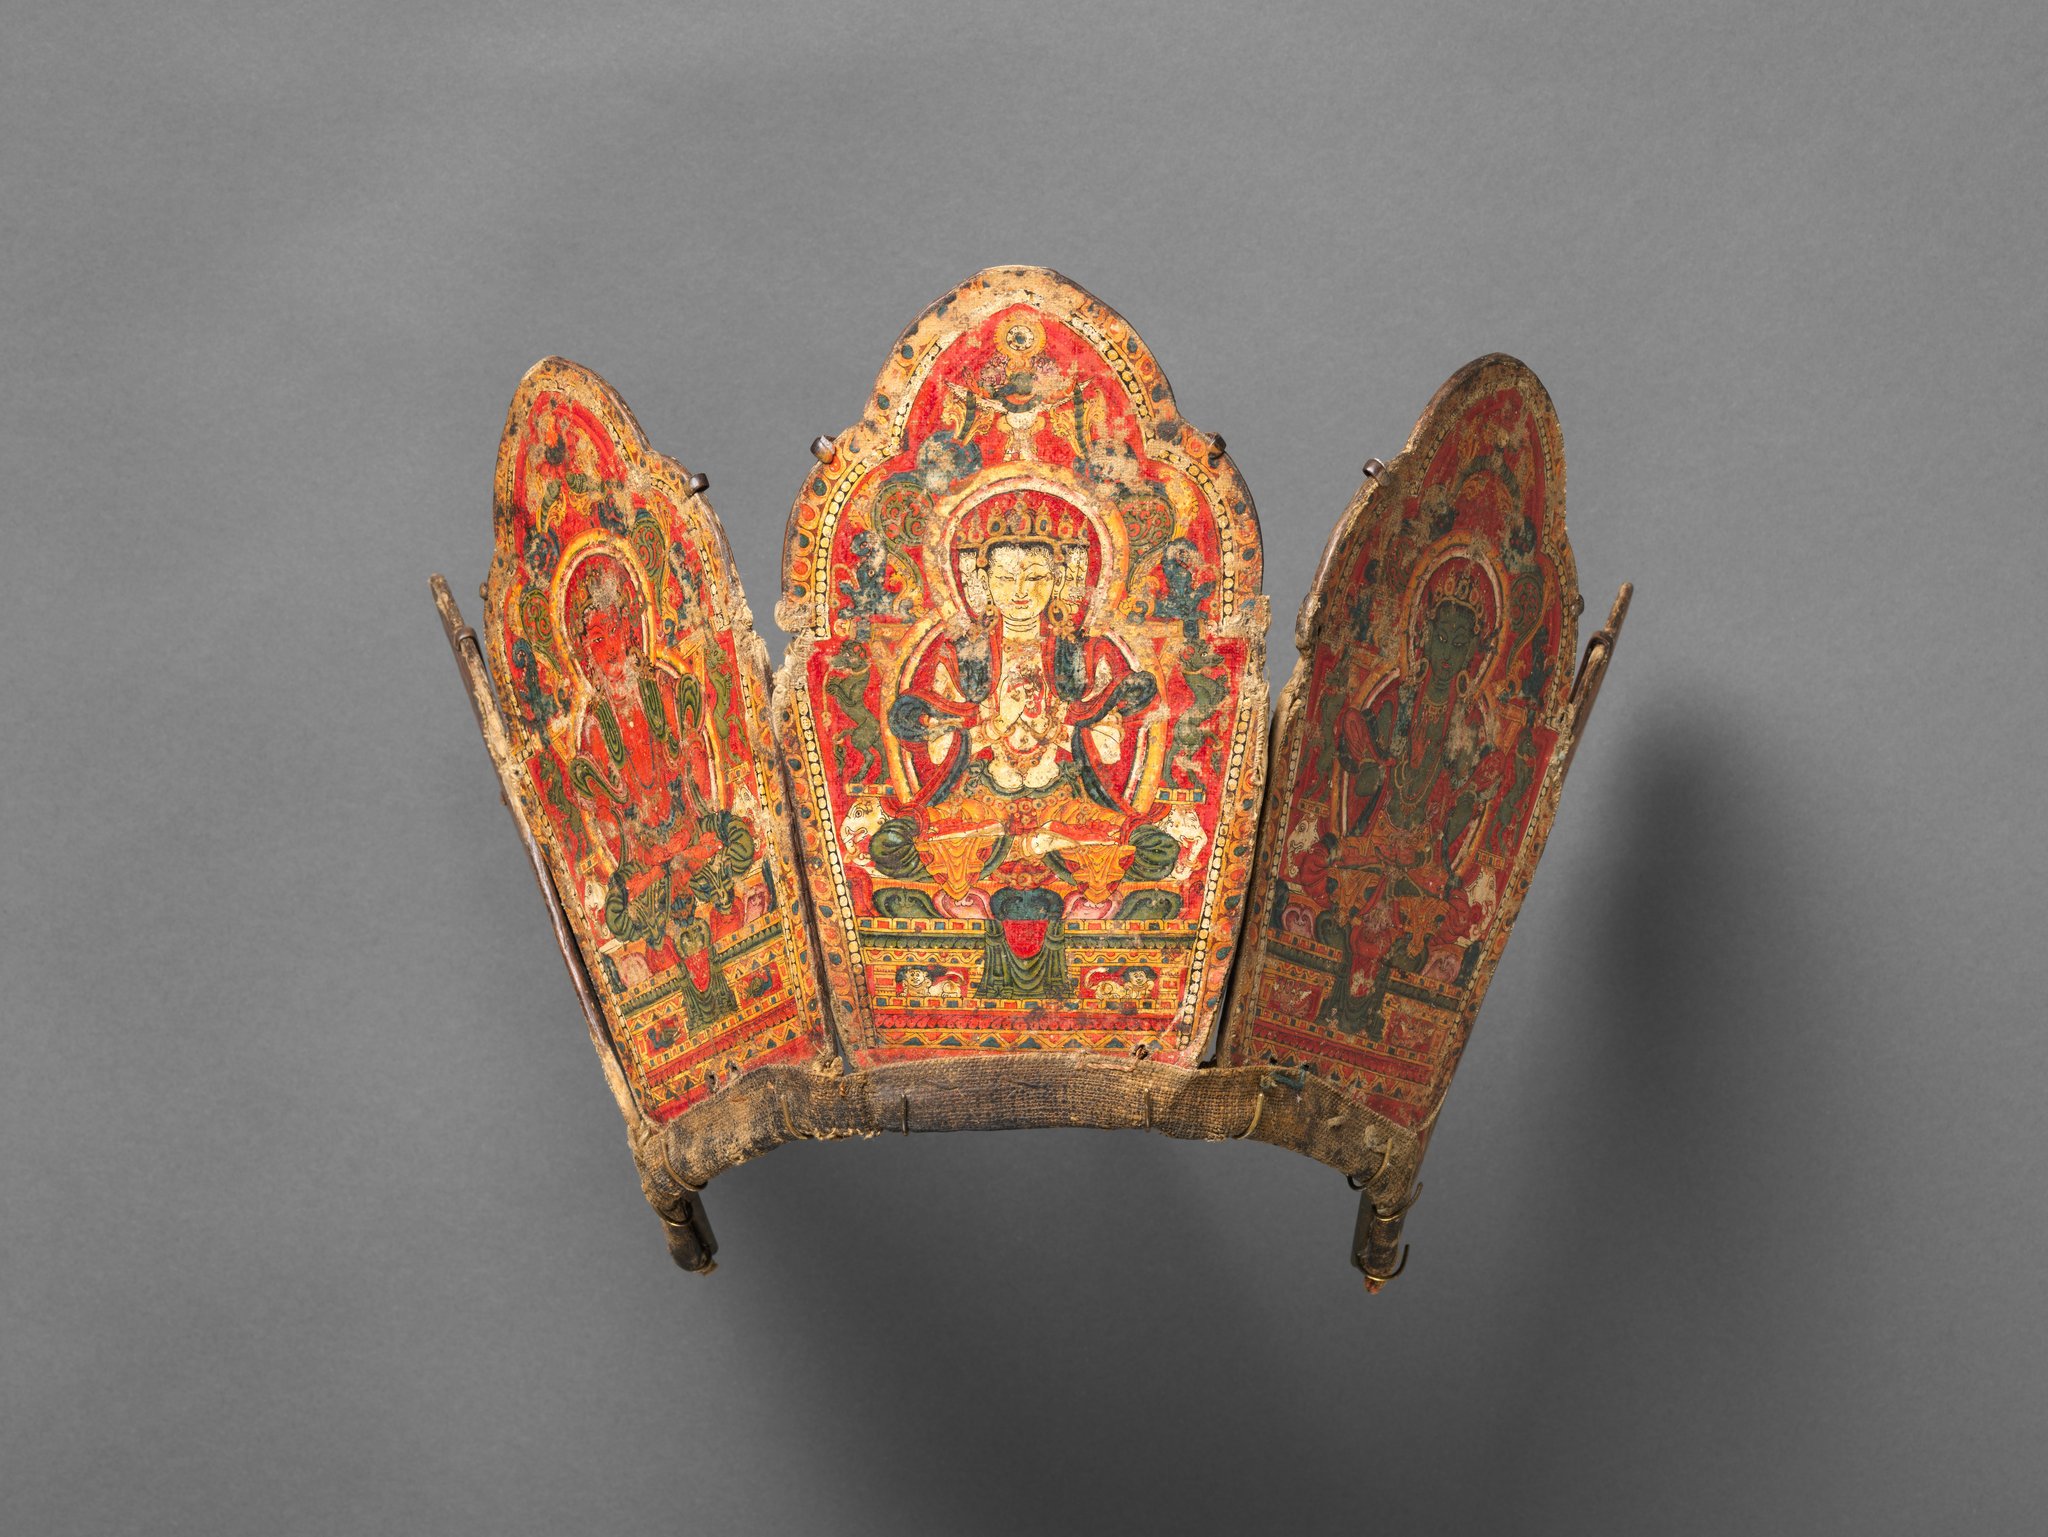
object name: ritual crown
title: Ritual Crown with the Five Transcendent Buddhas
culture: tibetan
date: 1367-1433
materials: board, gold, watercolor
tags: buddhism,buddha